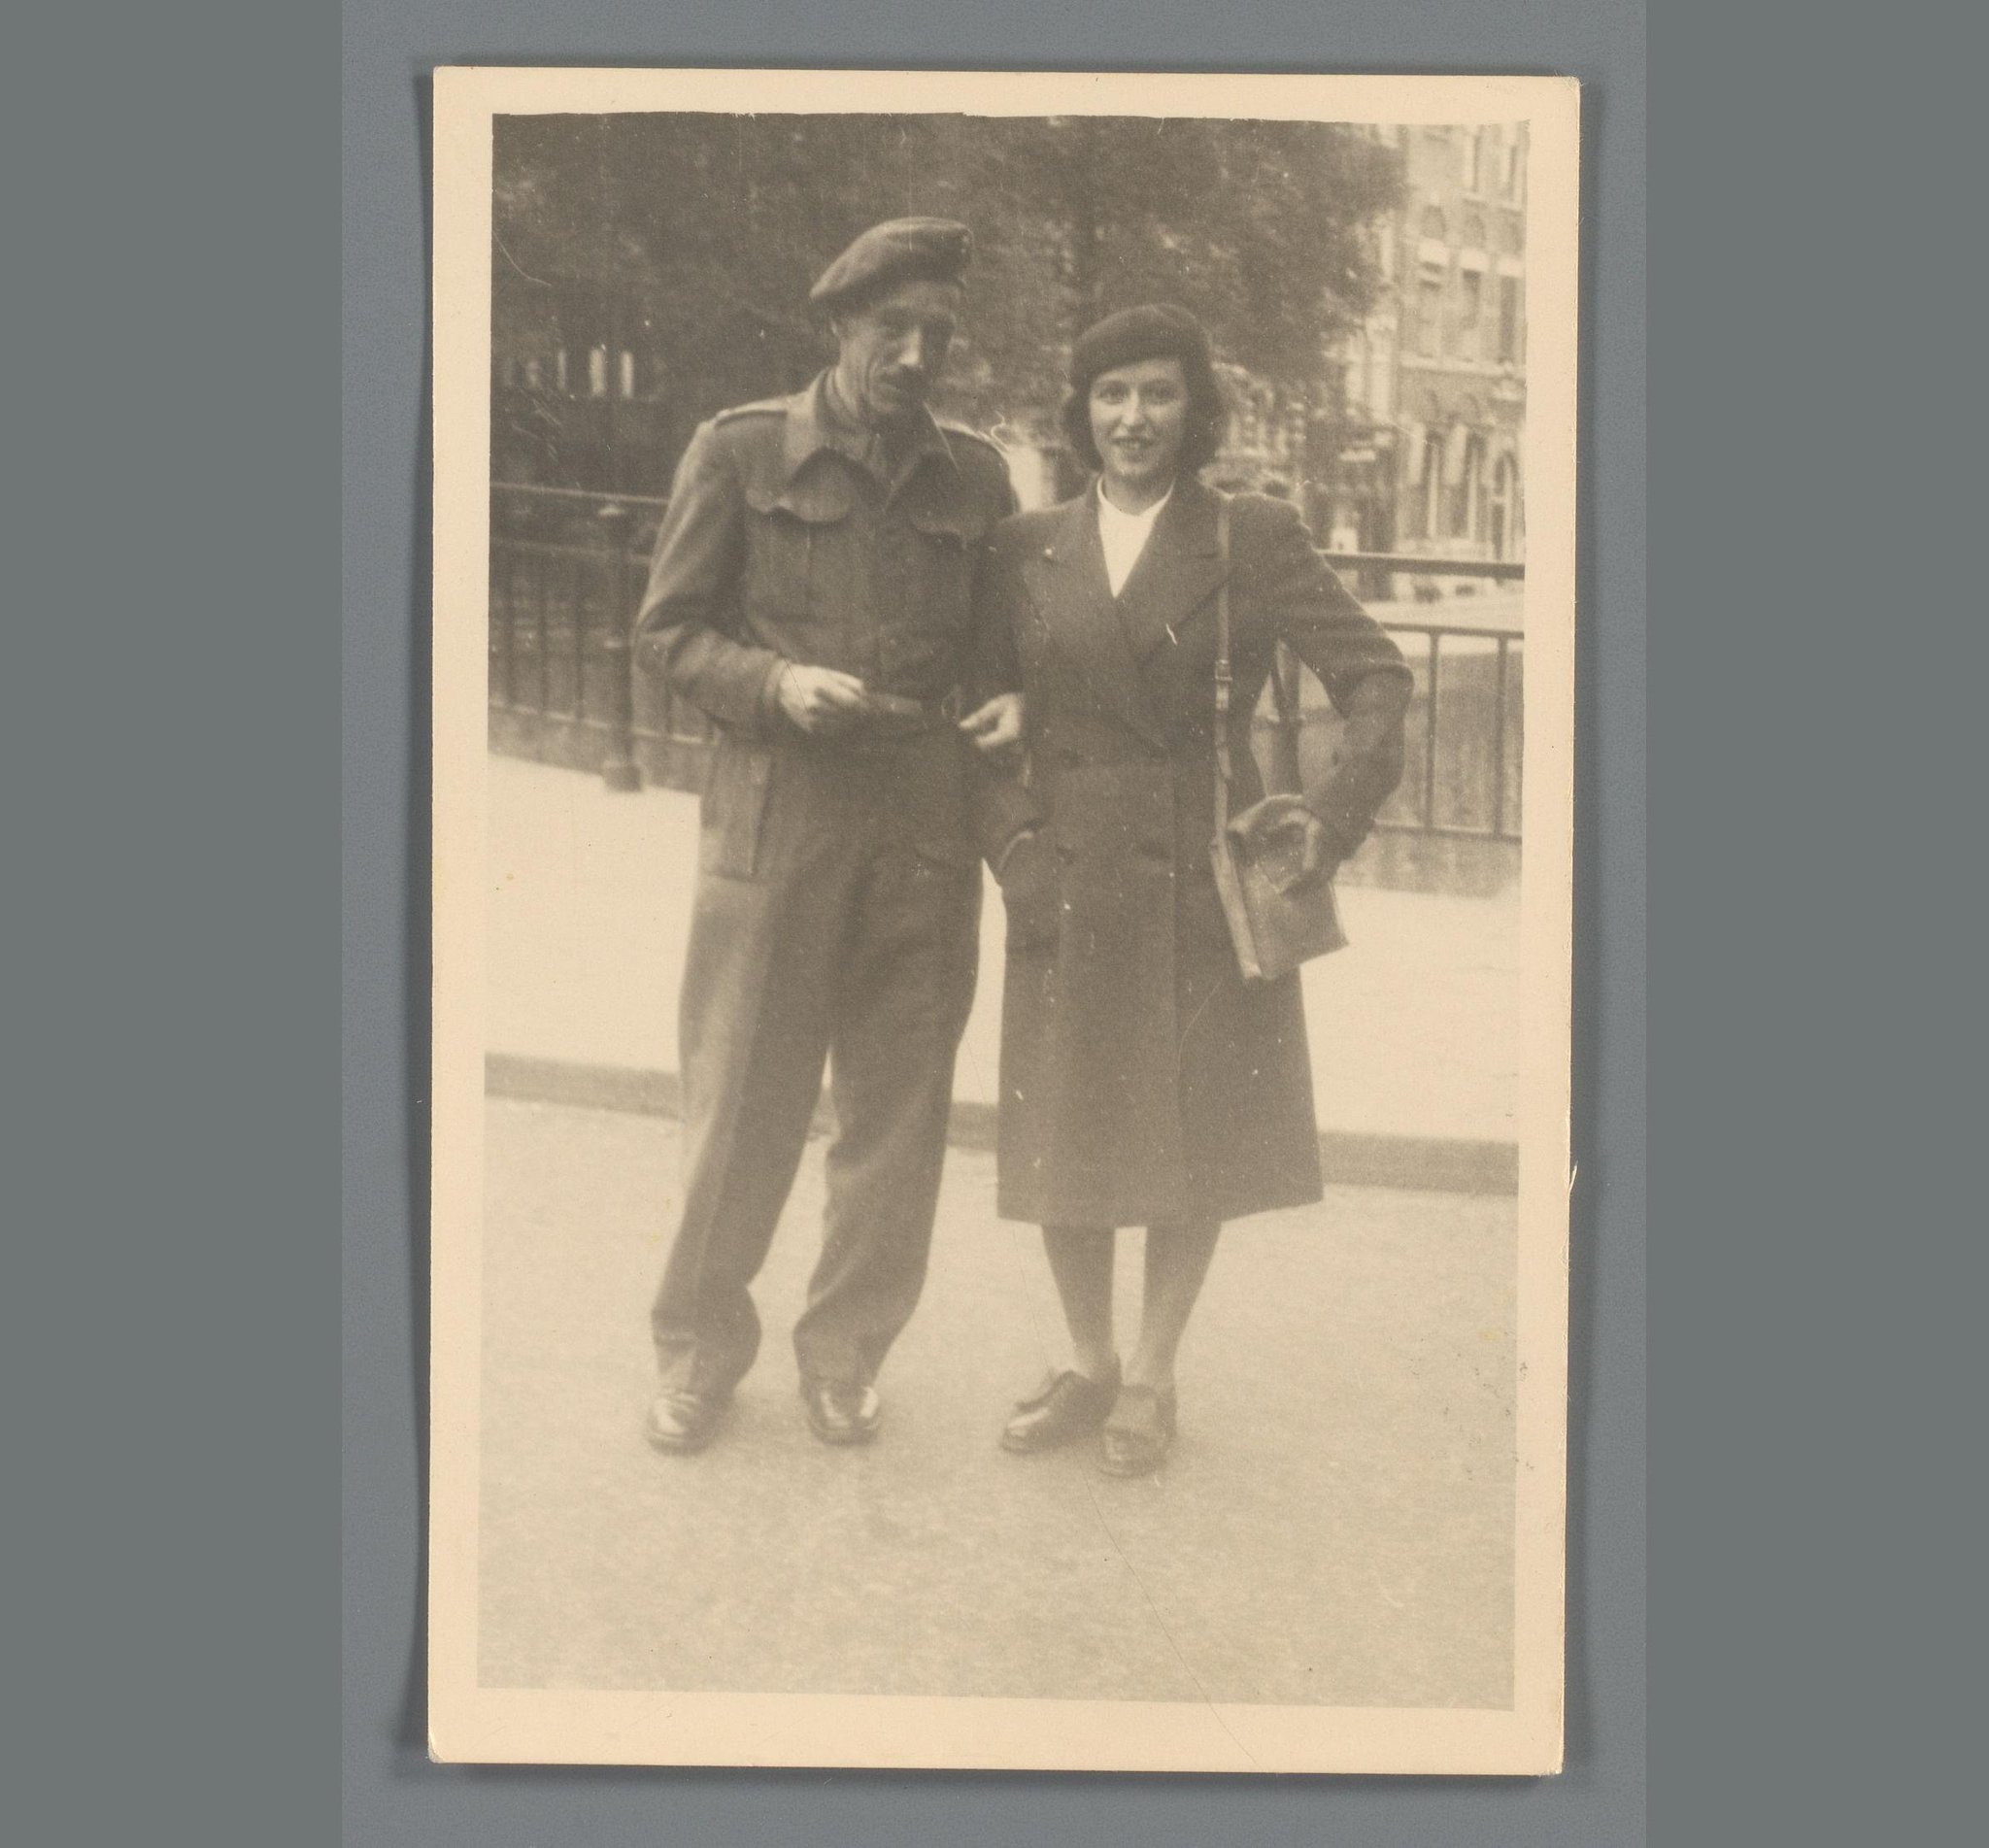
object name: photograph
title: Portret van een onbekende Britse militair en een jonge vrouw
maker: Anonymous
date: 1945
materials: paper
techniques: gelatin silver print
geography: netherlands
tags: (military) uniforms, historical persons not known by name, netherlands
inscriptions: date: ‘6 oct 1945’